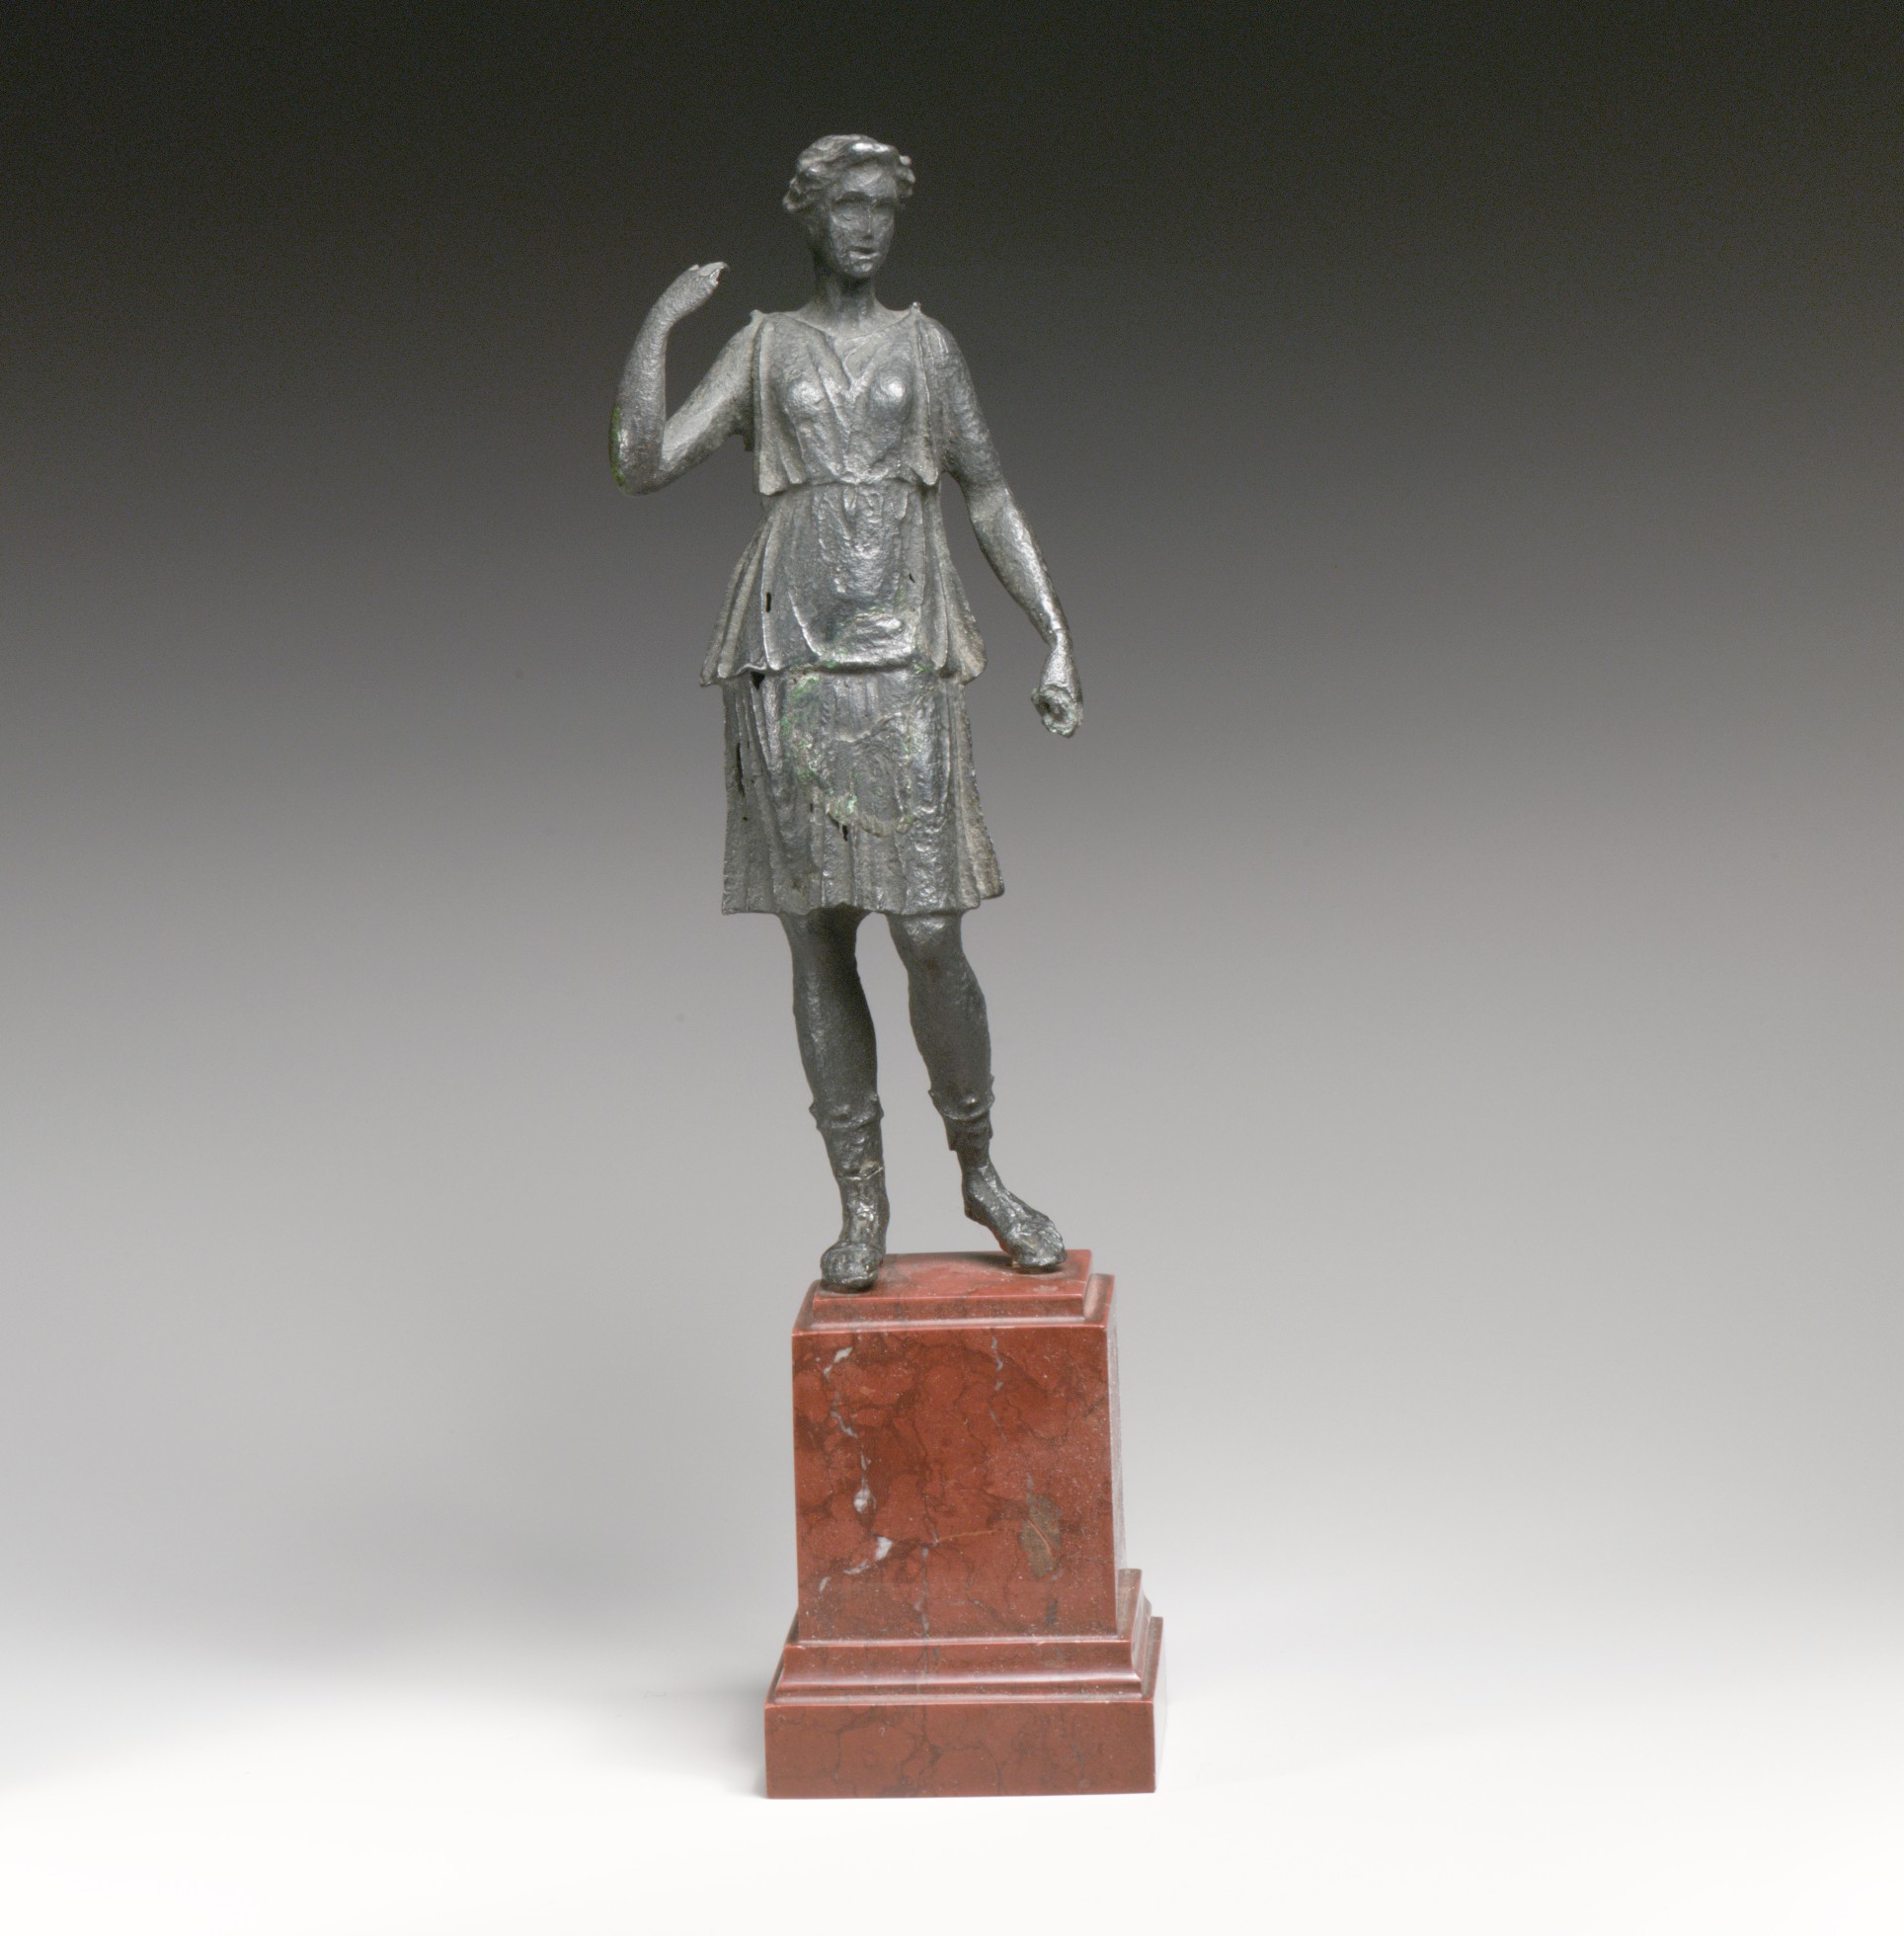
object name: statuette of artemis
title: Bronze statuette of Artemis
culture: greek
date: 300-1 BCE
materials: bronze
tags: artemis